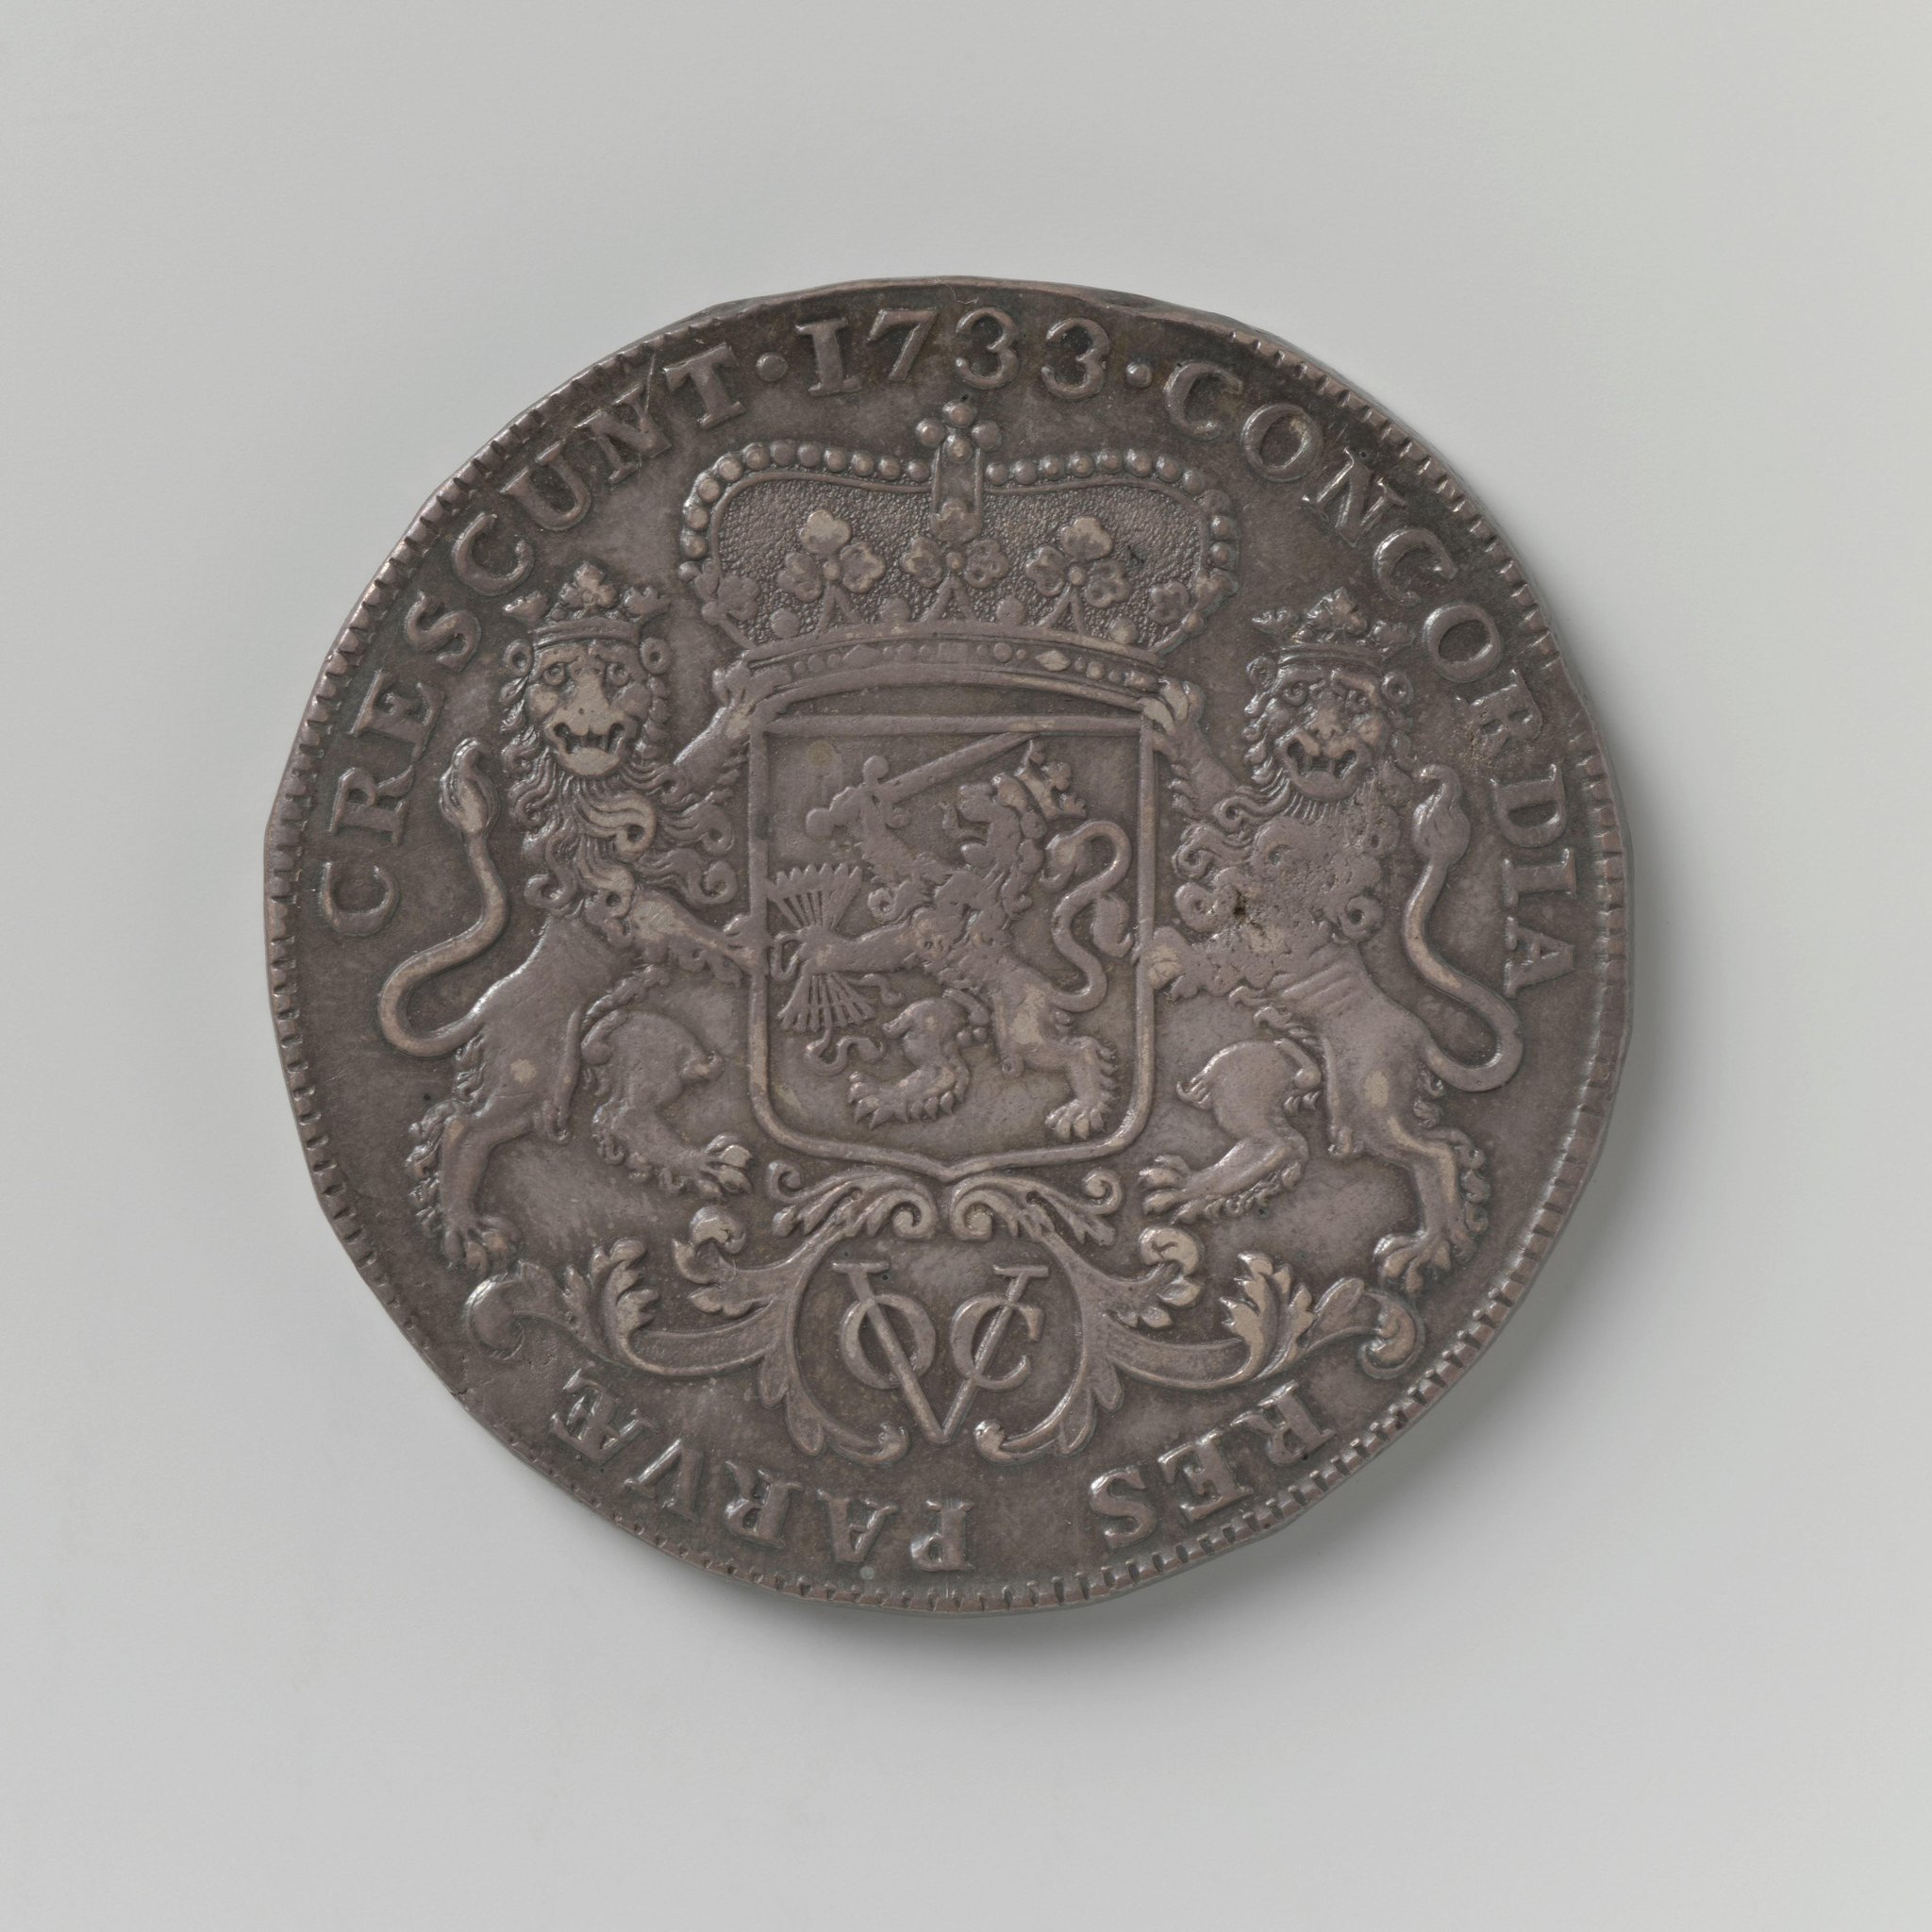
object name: silver rider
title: Zilveren rijder van de VOC uit Holland, 1733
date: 1733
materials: silver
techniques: striking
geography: dordrecht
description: Zilveren munt. Voorzijde: geharnaste ridder met zwaard te paard naar rechts, waaronder gekroond wapenschild van Holland. Keerzijde: gekroond generaliteitswapenschild, waaronder cartouche, waarin monogram van de VOC. Jaartal in omschrift, boven kroon. Gladde rand.